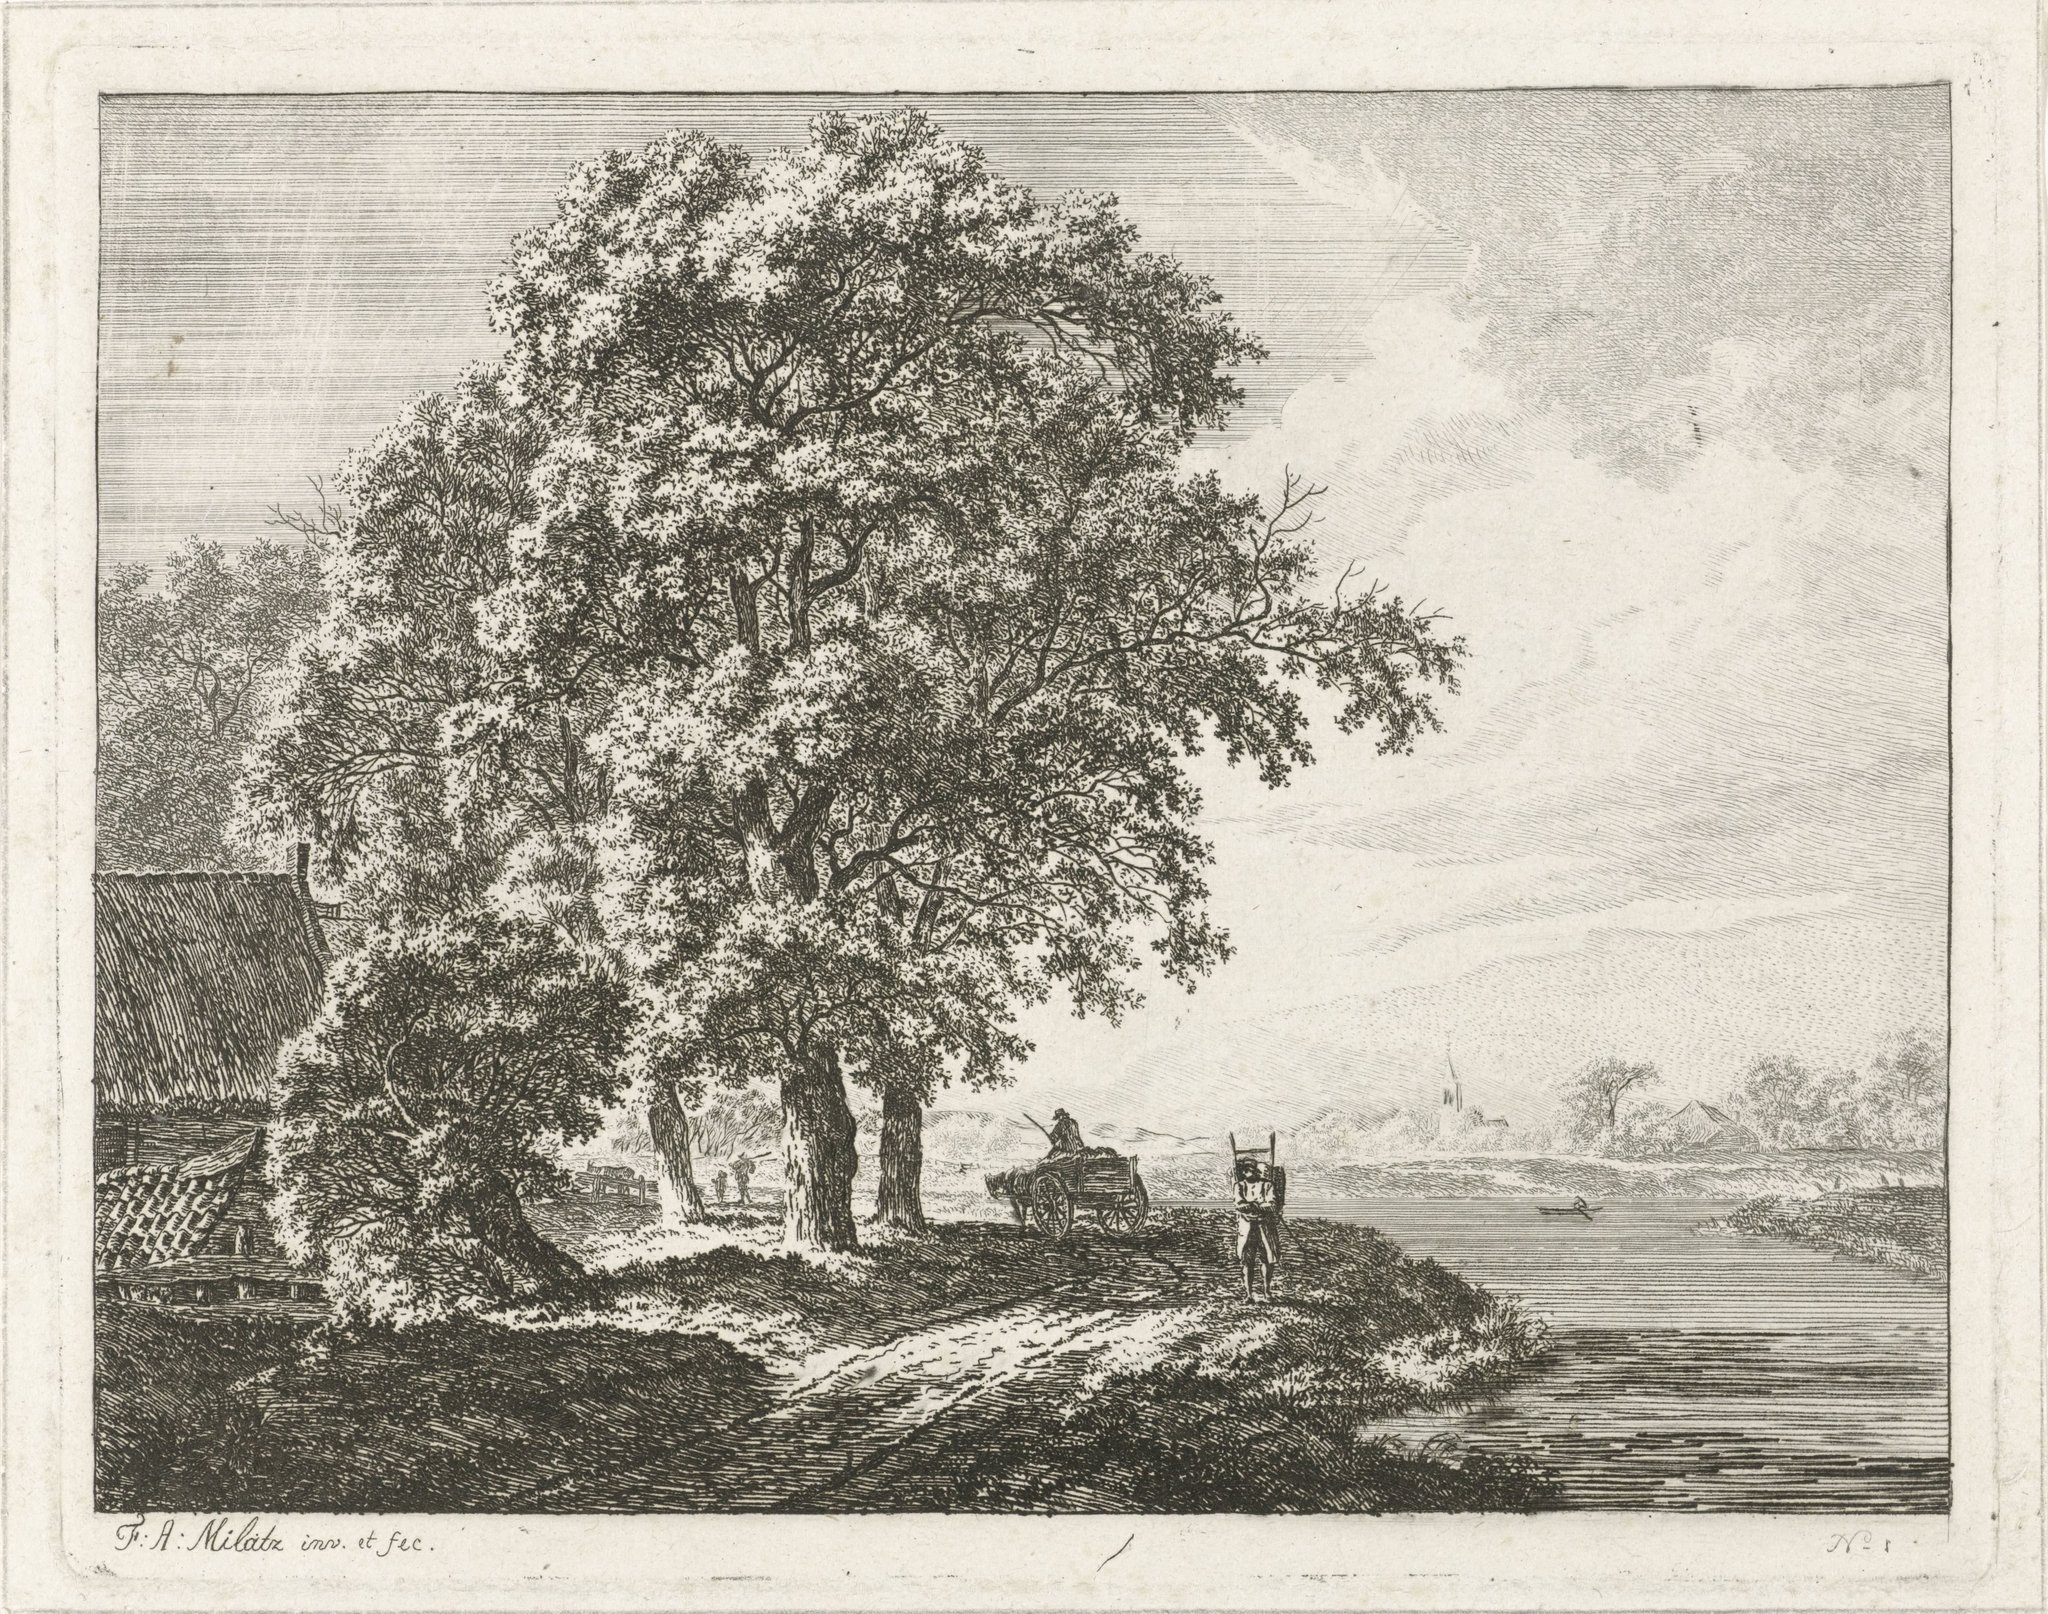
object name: print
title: Landschappen met bomen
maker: franciscus andreas milatz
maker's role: draughtsman, painter, print maker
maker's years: 1764-1808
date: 1784-1808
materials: paper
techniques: etching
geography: haarlem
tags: trees, river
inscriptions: collector's mark: Lugt 2228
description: Landschap met hoge bomen langs een rivier. Op de weg een boerenkar en een man met een pak op zijn rug.